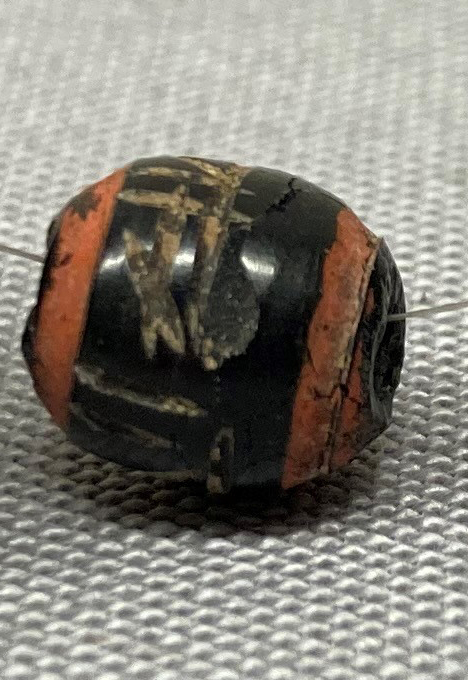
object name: bead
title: Stone Beads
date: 701-1200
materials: stone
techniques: incising, painting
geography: iran